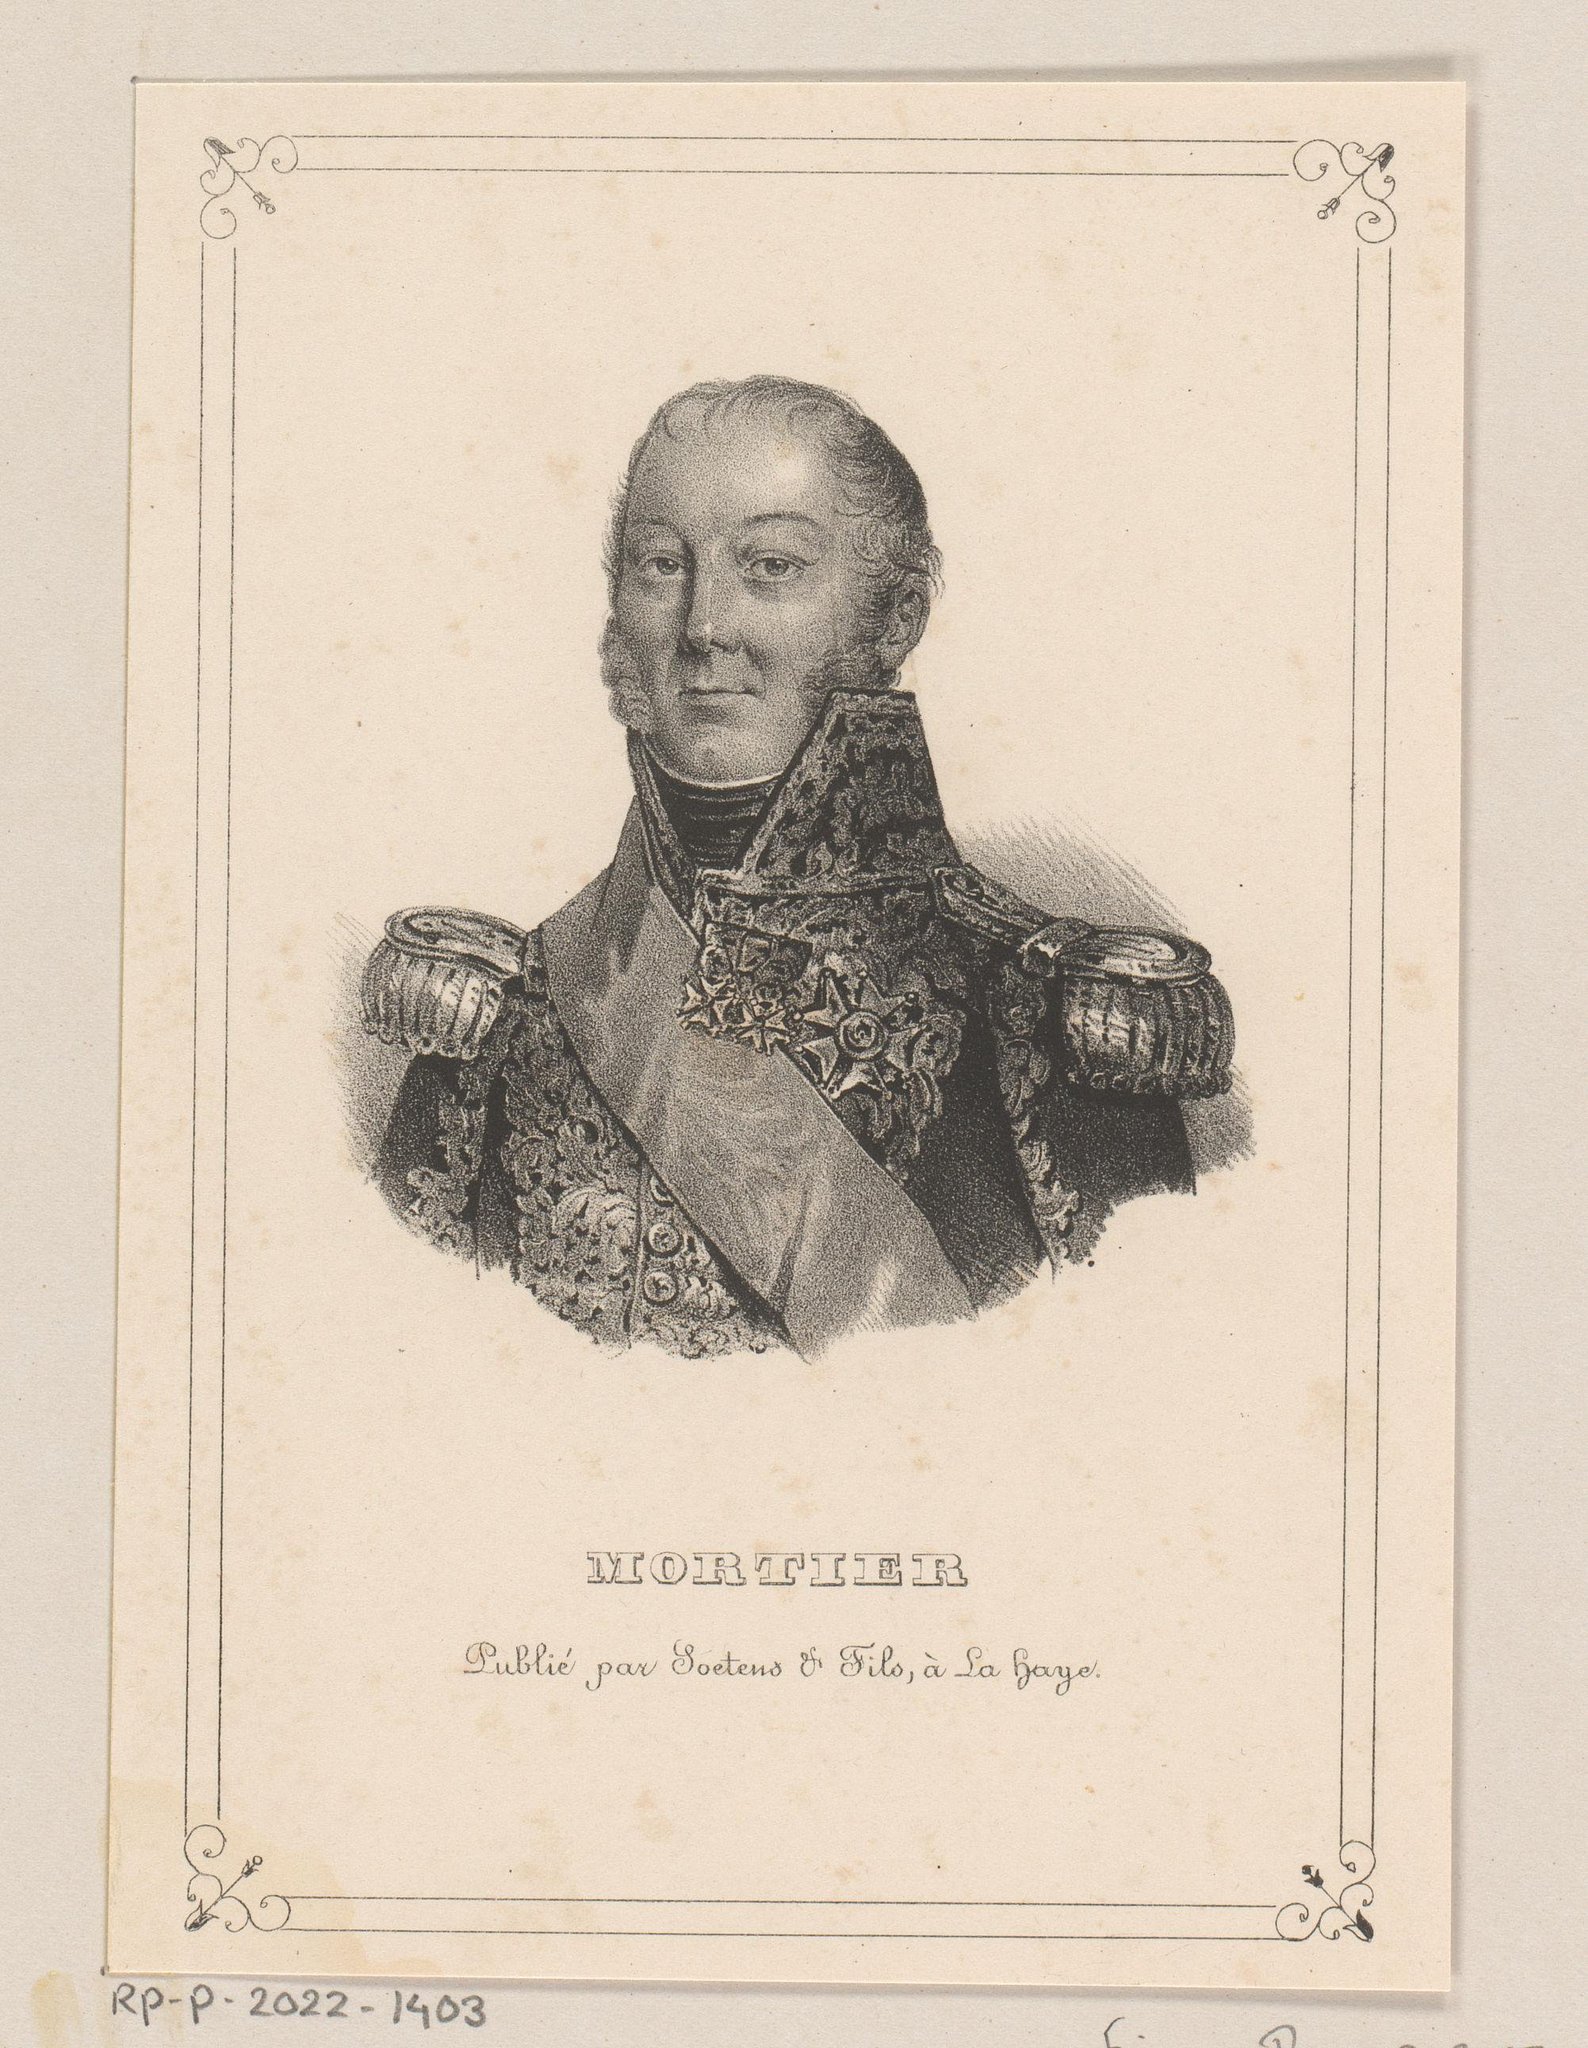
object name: print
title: Portret van Édouard Mortier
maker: Anonymous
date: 1837-1840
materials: paper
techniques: lithograph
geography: the hague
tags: paris, commander-in-chief, general, marshal, historical persons